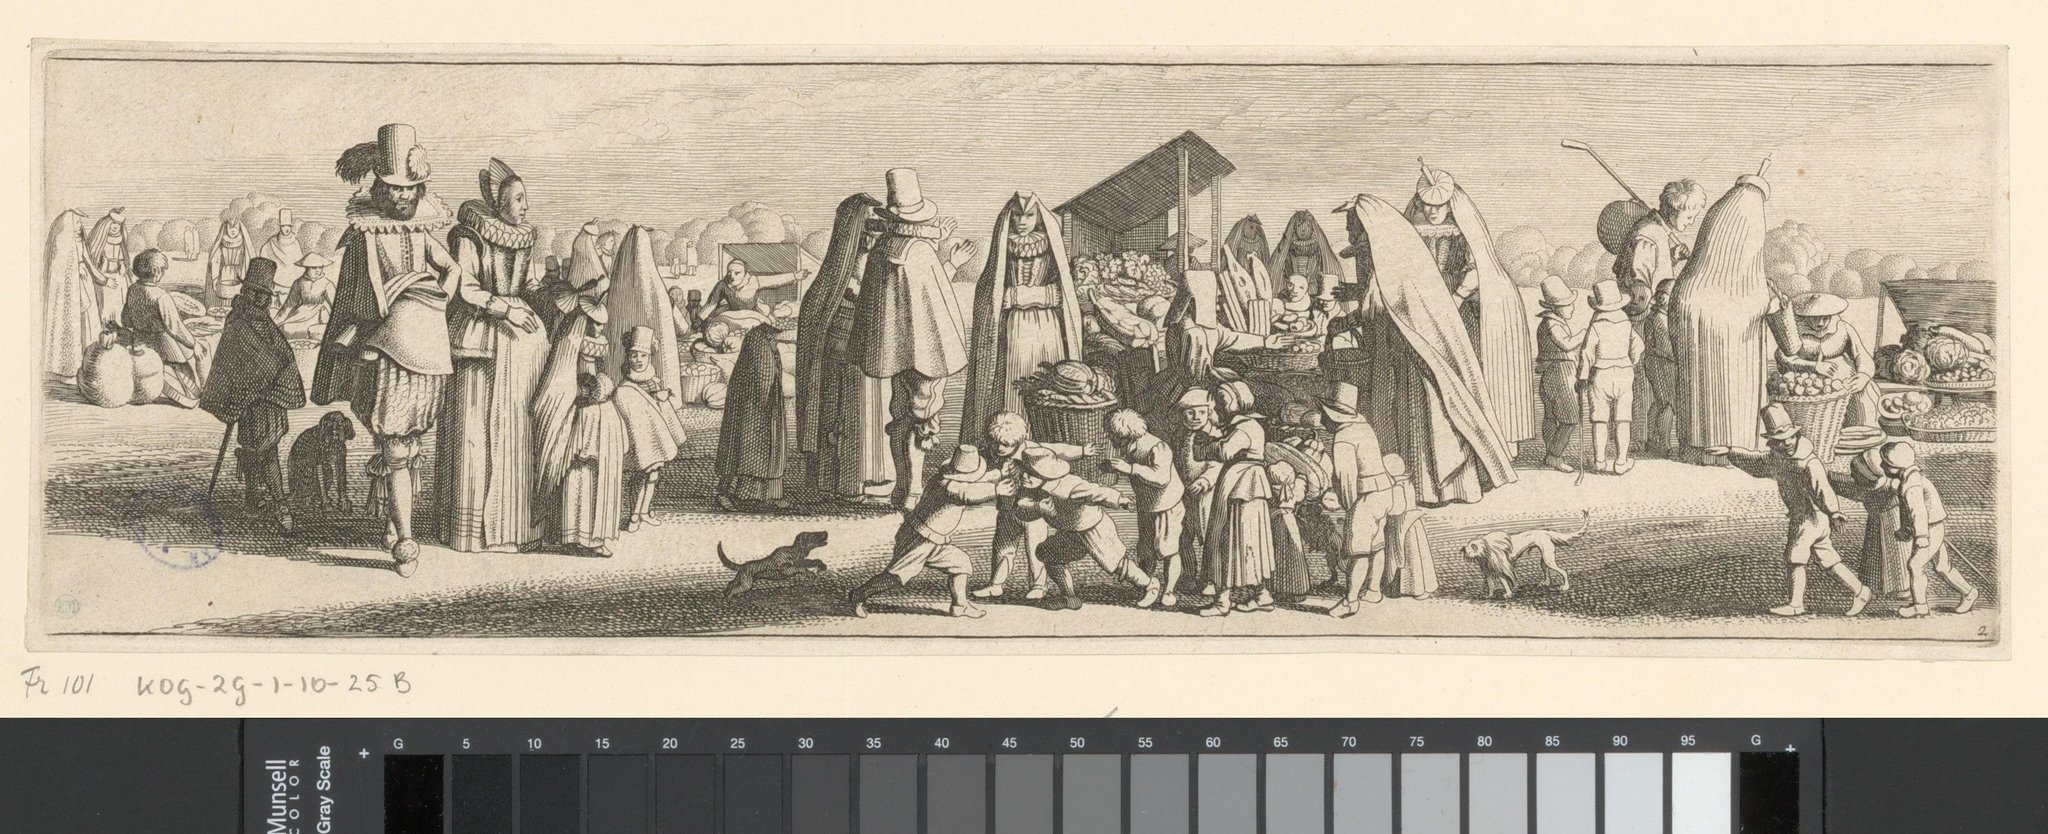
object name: print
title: Figuren bij groentekramen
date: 1603-1652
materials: paper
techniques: engraving, etching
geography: amsterdam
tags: cape (huik) (+ women's clothes), quack, charlatan, mountebank, 'saltimbanco', clothes, costume (+ women's clothes), clothes, costume (+ men's clothes), market, person addressing a group, orator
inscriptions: collector's mark: Lugt 1934, collector's mark: Lugt 1641, collector's mark: Lugt 5100, stamp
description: Elegant geklede dames en heren op een groentemarkt. Rechts een groentekraam waarvoor enkele dames, gekleed in huik. Links op de voorgrond een paar met kinderen. Op de voorgrond een groep kinderen. Tweede prent van een fries bestaande uit vier prenten, voorstellende een markt. Rechtsonder genummerd: 2. Onderwerpsrubrieken binnen de Atlas Zeden en Gewoonten: Handel, nijverheid en verkeer, Marktwezen, Markttafereelen, Marktfiguren.